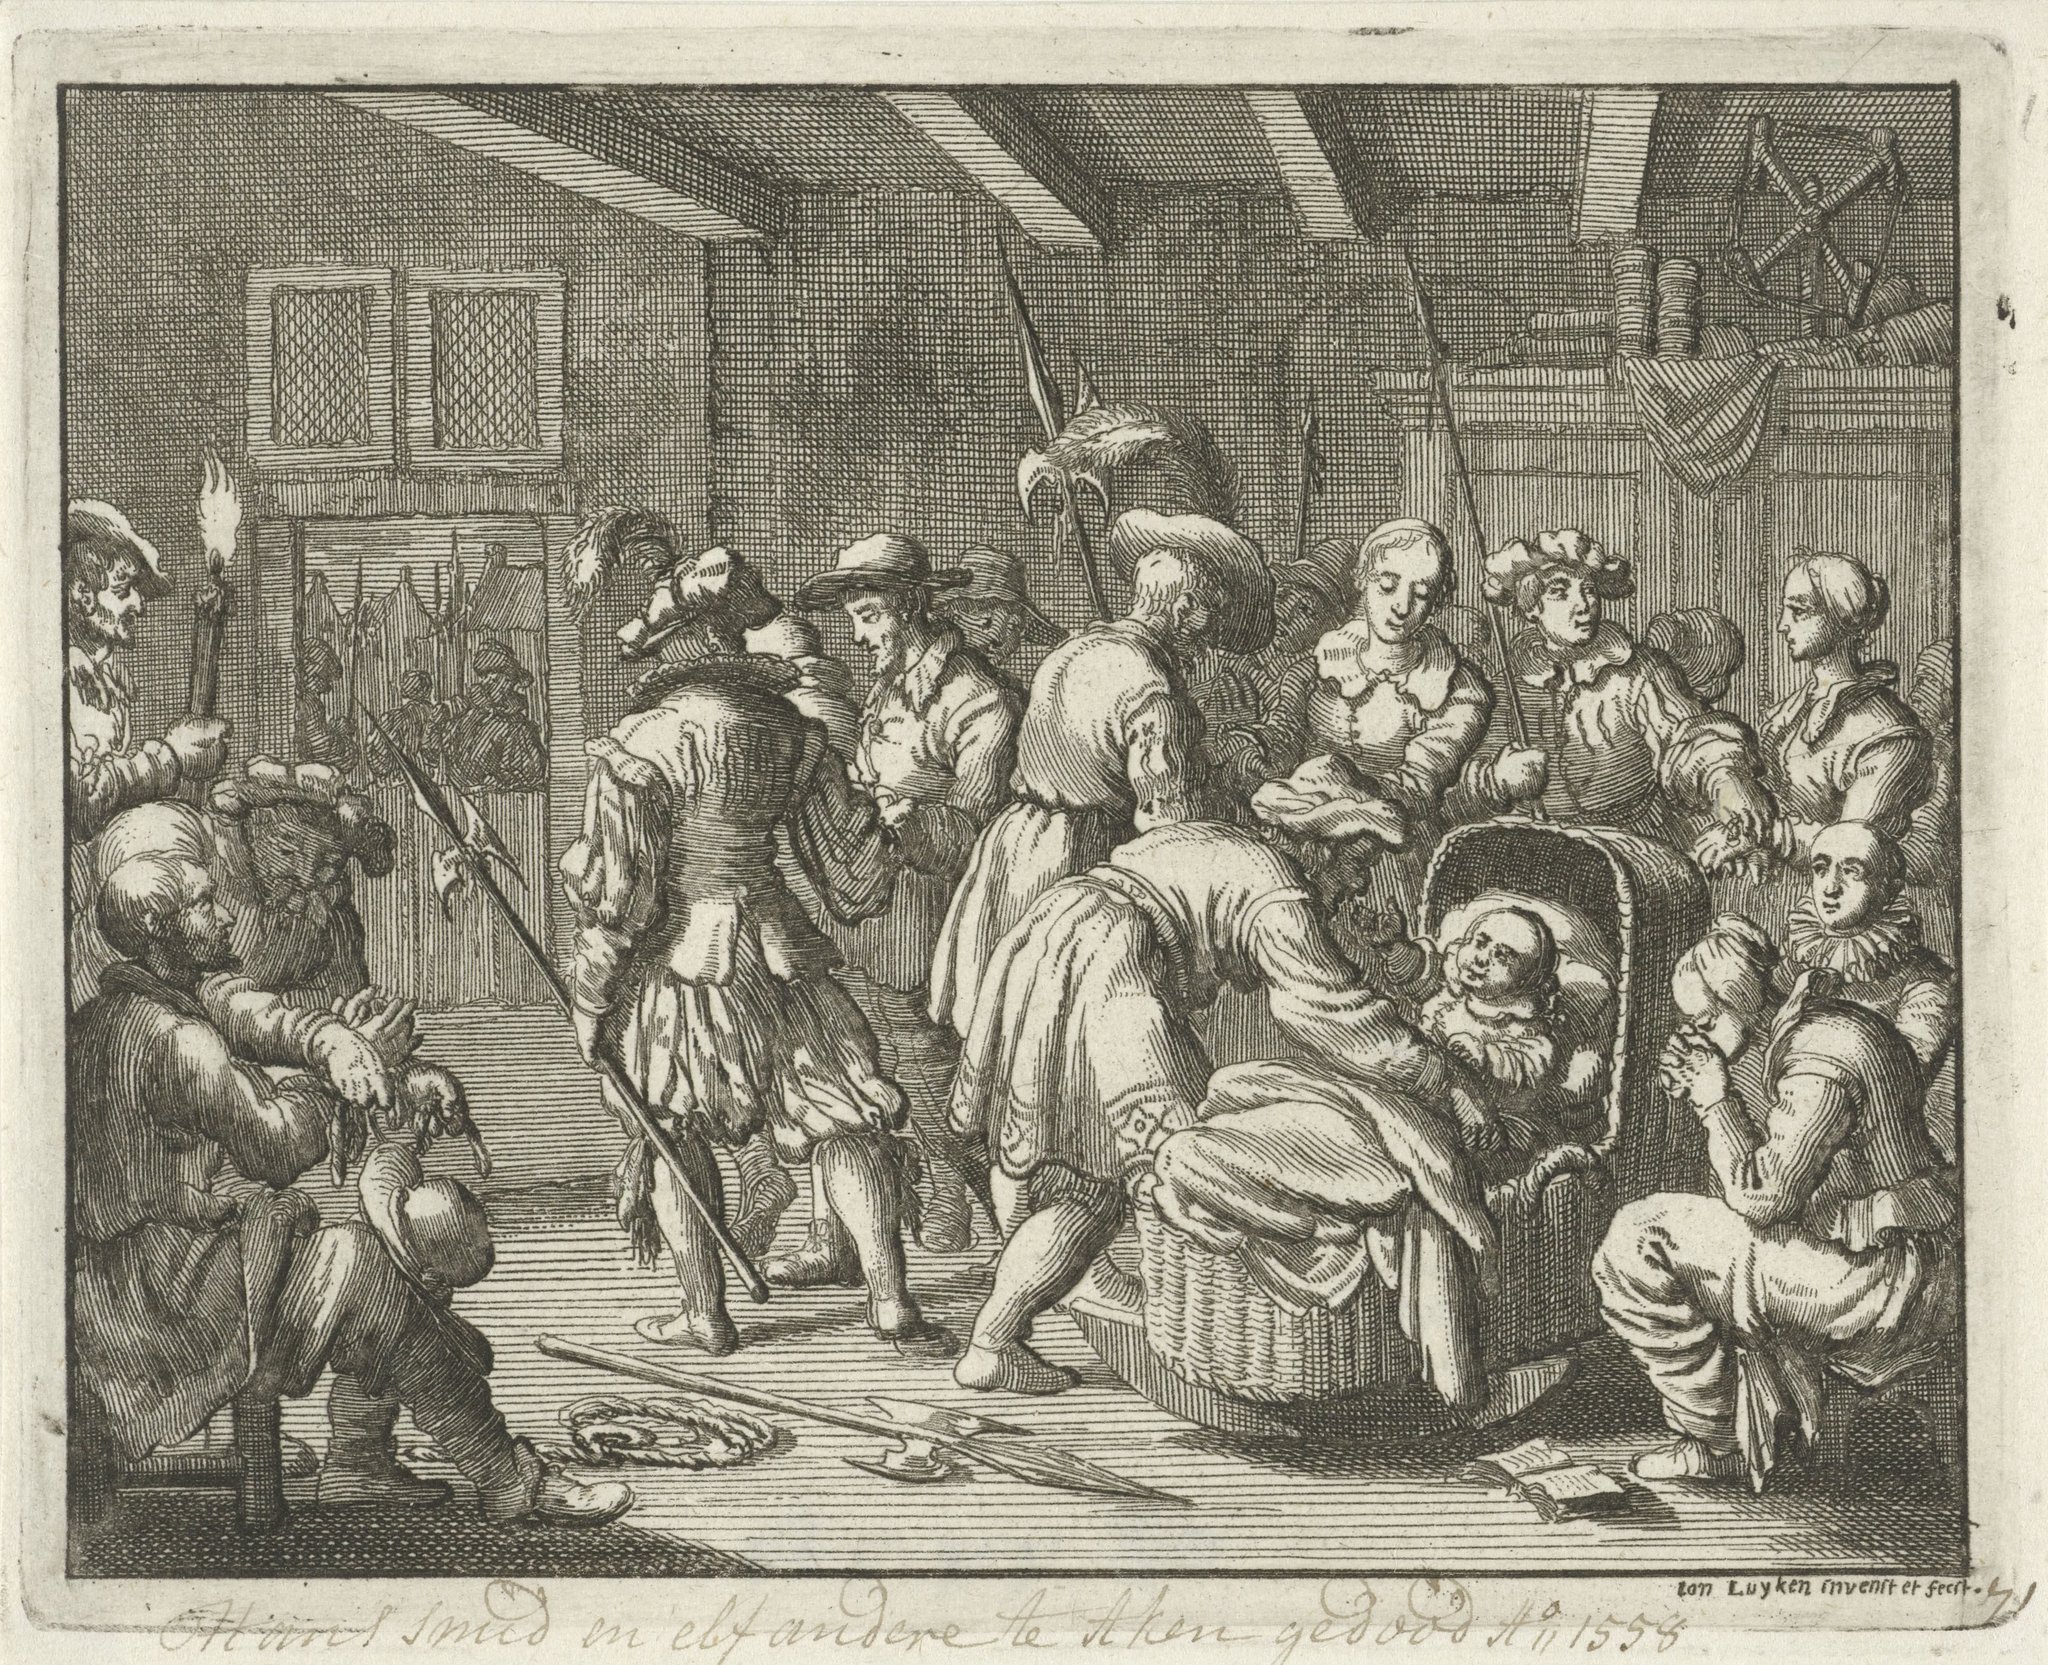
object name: print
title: Arrestatie van Hans Smit en elf anderen, 1558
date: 1685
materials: paper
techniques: etching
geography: amsterdam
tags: persecution of heretics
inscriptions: collector's mark: Lugt 2228, inscription: ‘Hans Smid [...] Ao 1558’, number: ‘71’